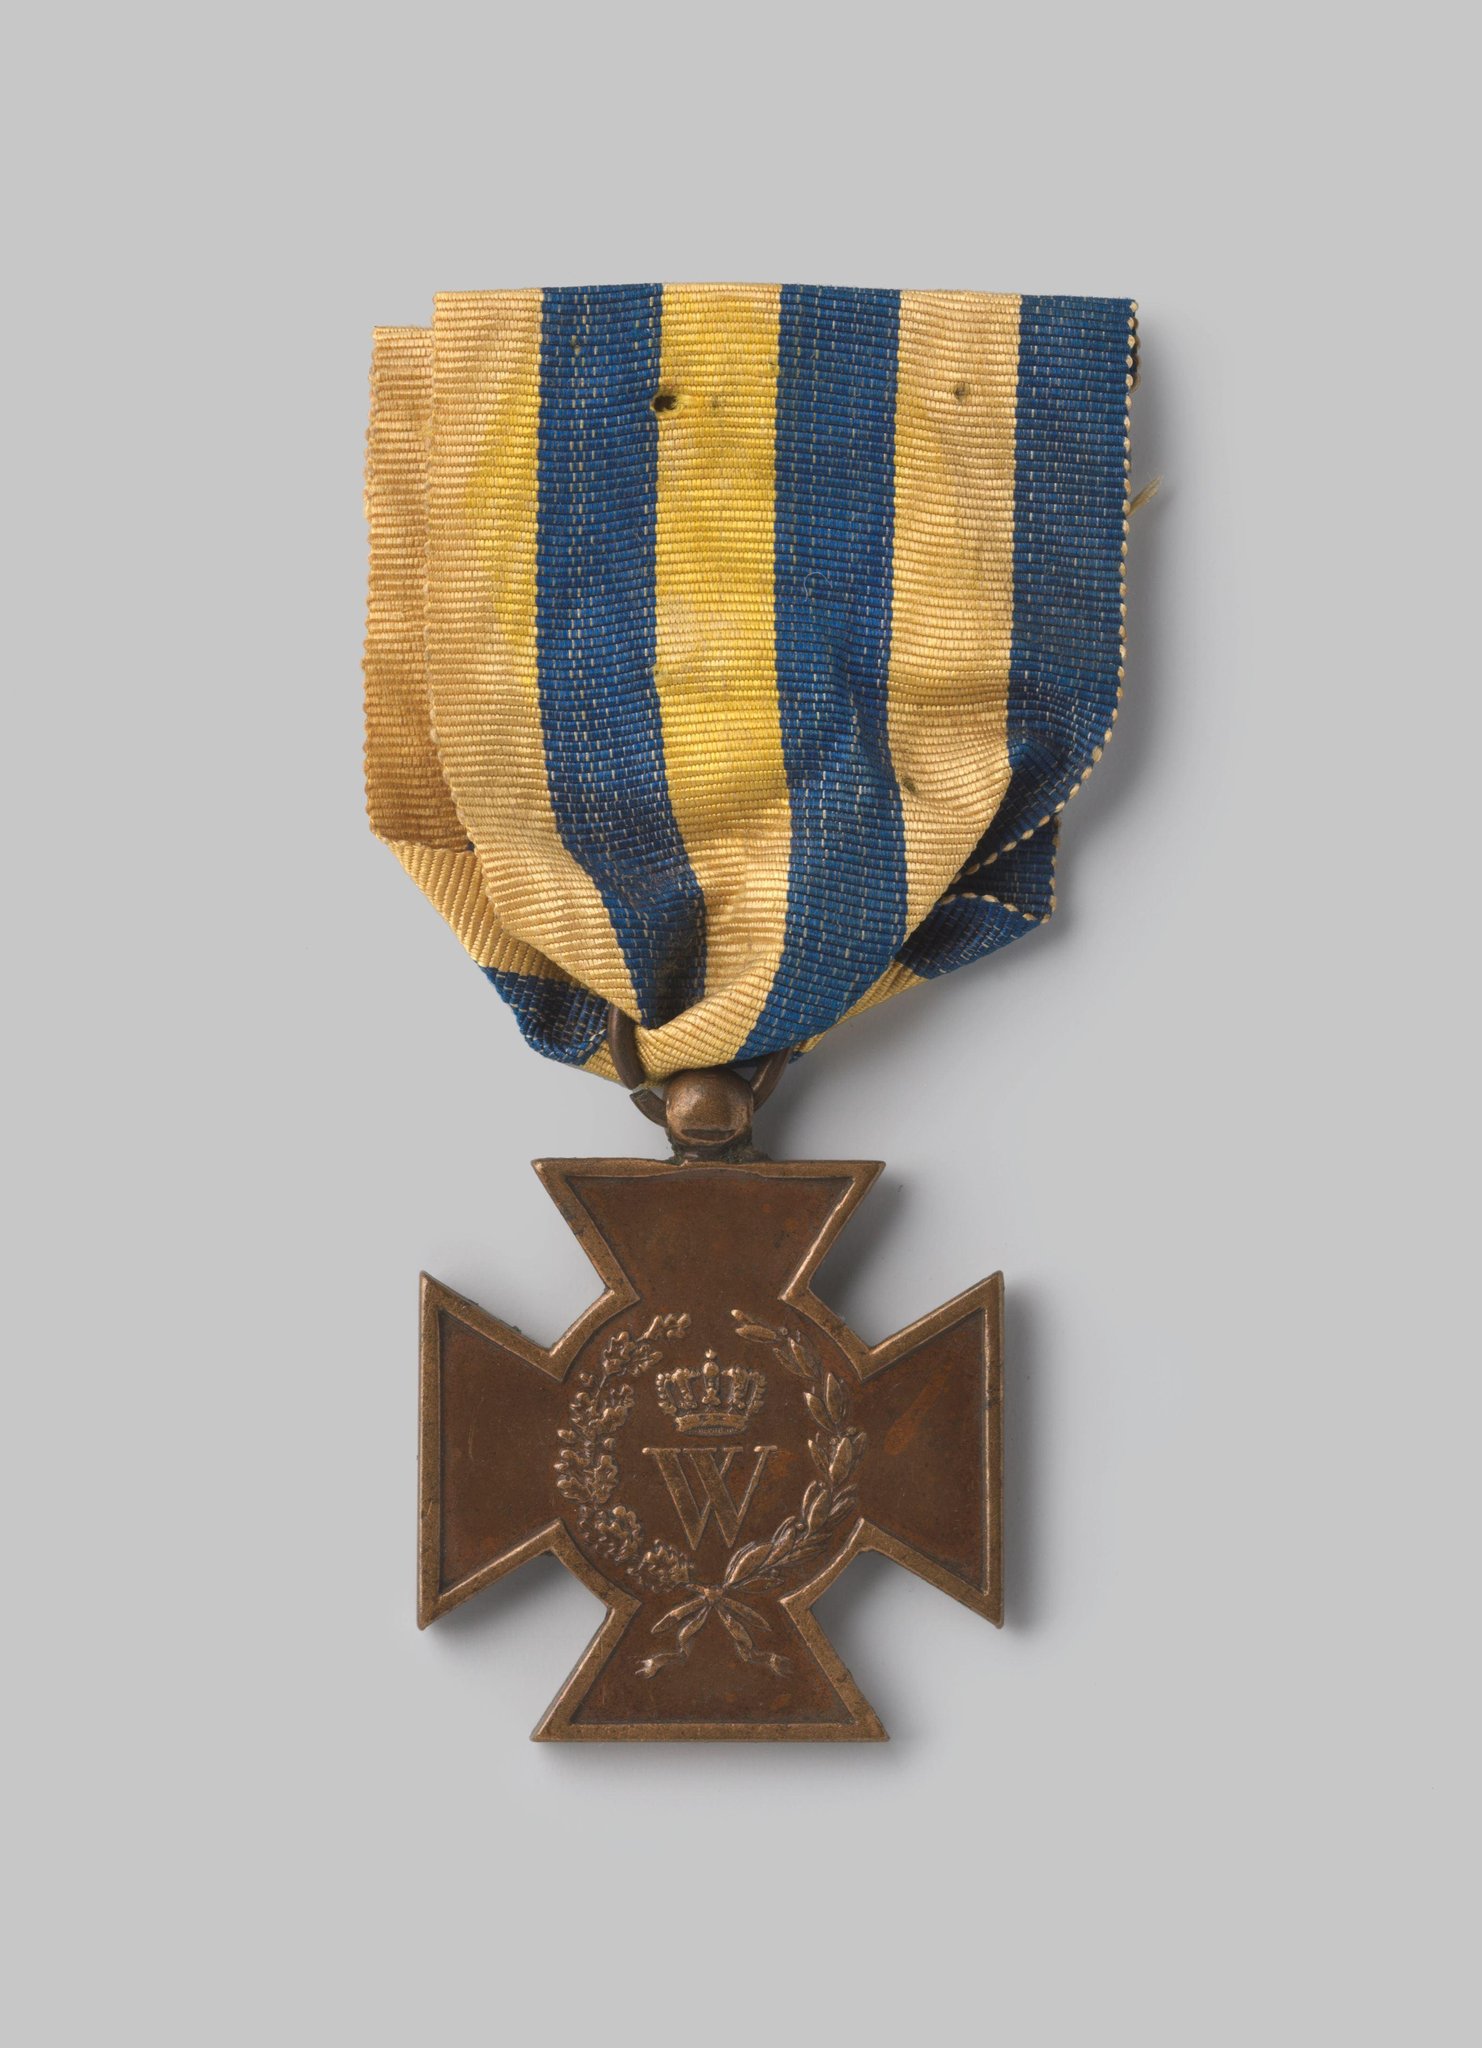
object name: onderscheidingsteken, onderscheiding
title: Metalen Kruis 1830-1831met blauw-geel lint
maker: Anonymous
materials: bronze, textile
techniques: forging, striking, weave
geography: netherlands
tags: metalen kruis, belgische revolutie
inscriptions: : ‘TROUW AAN/ KONING/ EN/ VADERLAND’, : ‘gekroonde W’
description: Metalen kruis 1830-1831 met vier bronzen armen. Aan de voorzijde een gekroonde W omgeven door aan de linkerzijde eikenbladeren en aan de rechterzijde laurierbladeren welke elkaar onder de gekroonde W overlappen. Aan de achterzijde van het kruis een tekst op iedere arm, aan de bovenzijde TROUW AAN, rechterzijde KONING, onderzijde EN, en aan de linkerzijde VADERLAND. Centraal staat het jaartal 1830-1831. Aan de bovenzijde een ring waaraan het driemaal verticaal gestreepte blauw-geel lint bevestigd is.